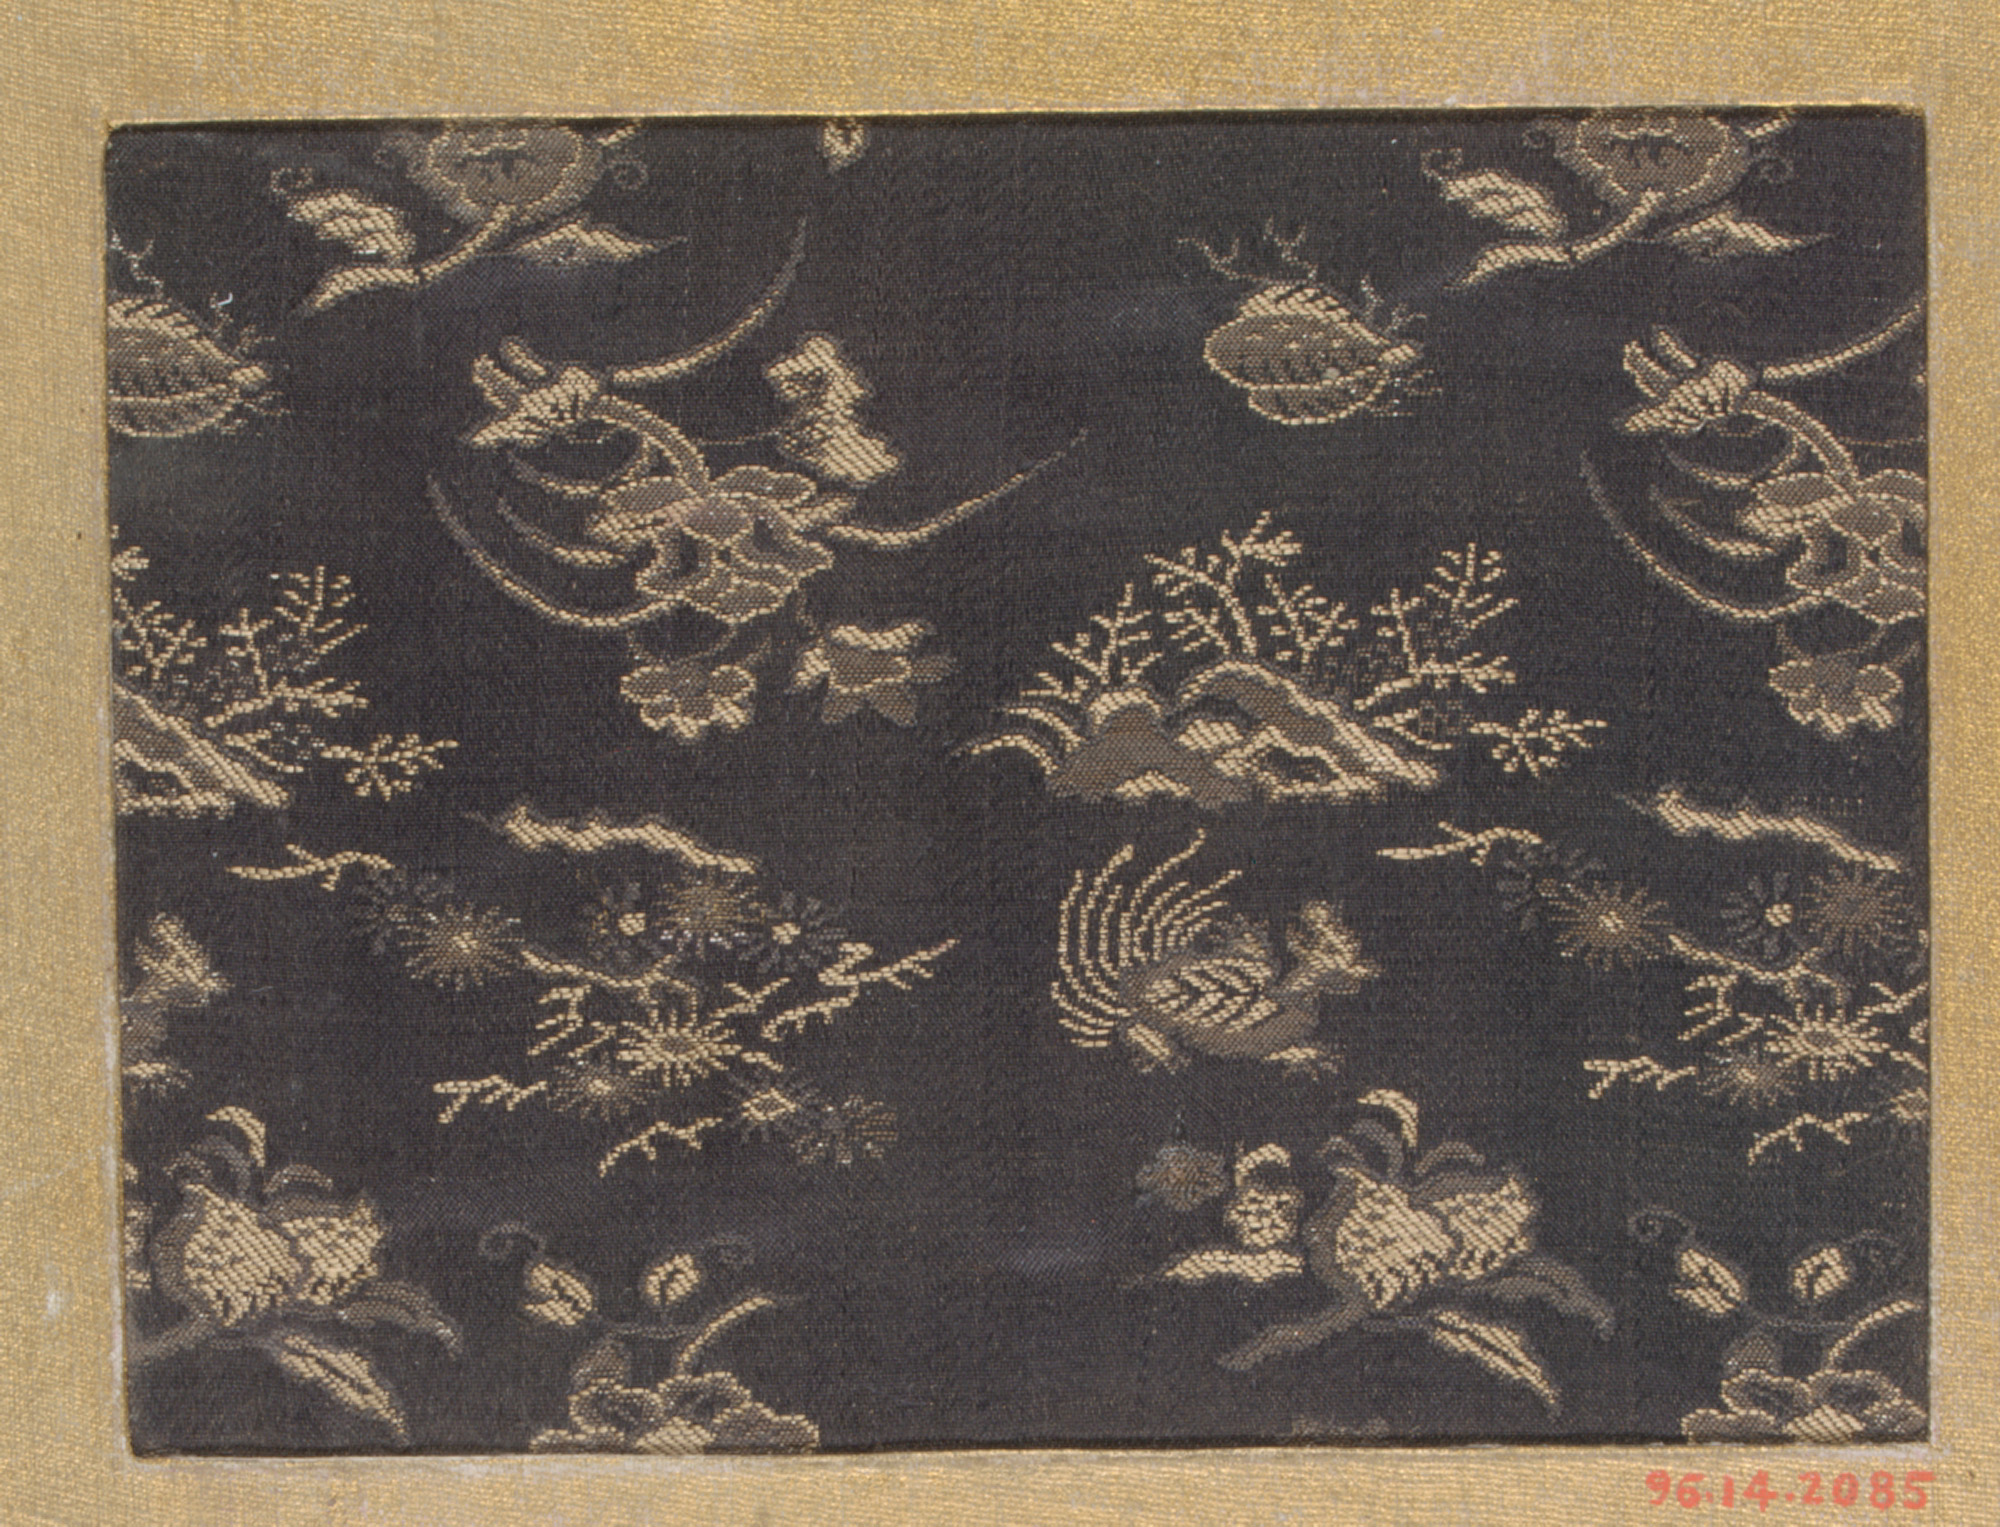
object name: piece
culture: japanese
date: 1701-1900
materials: silk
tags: flowers